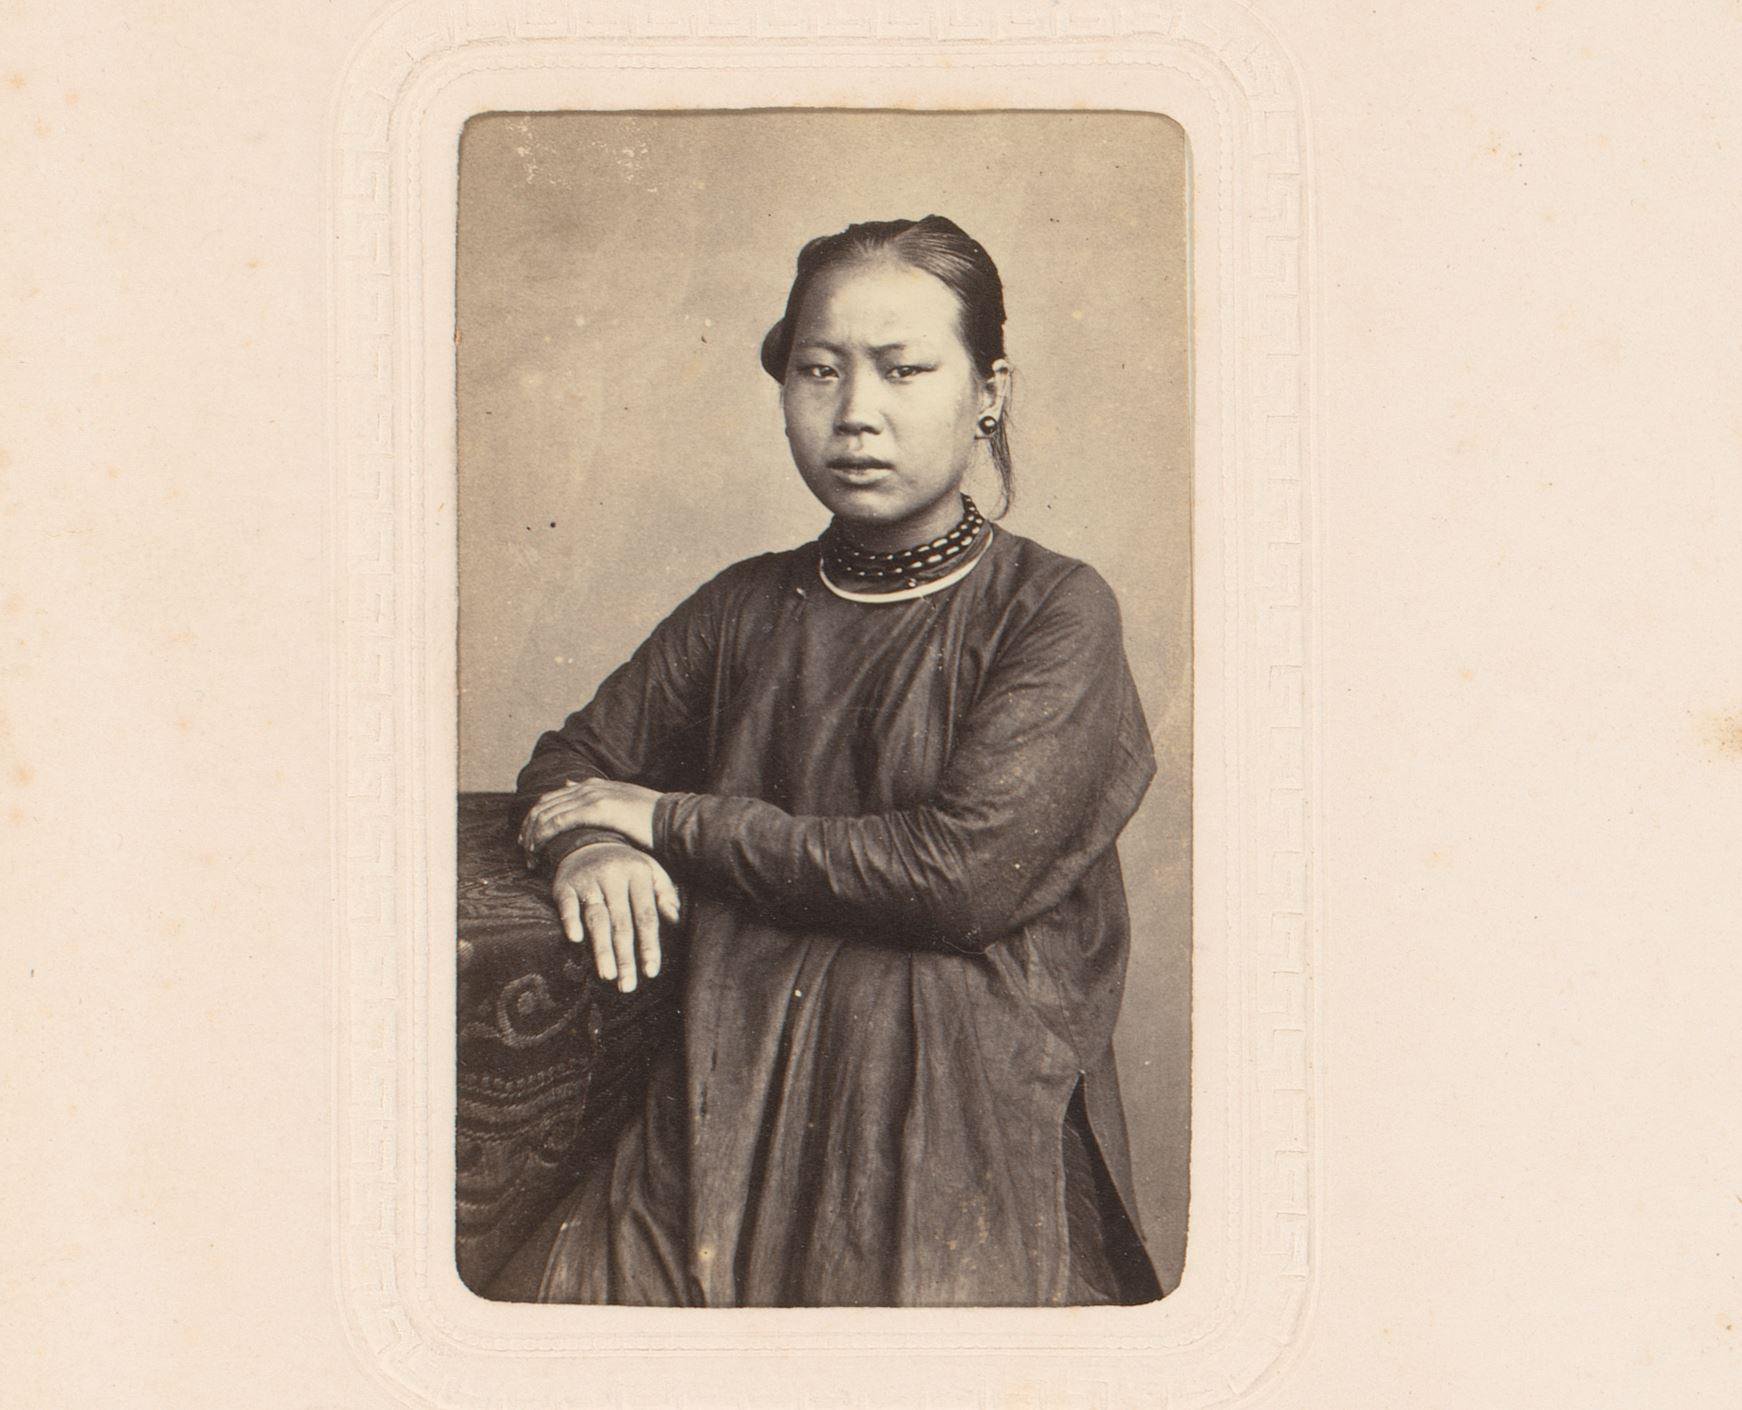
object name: album leaf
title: Portret van een vrouw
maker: Anonymous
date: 1850-1880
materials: cardboard, photographic support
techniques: albumen print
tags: historical persons - bb - woman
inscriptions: annotation: ‘Chinesisch: Madschen/ van Saigon’, number: ‘45’